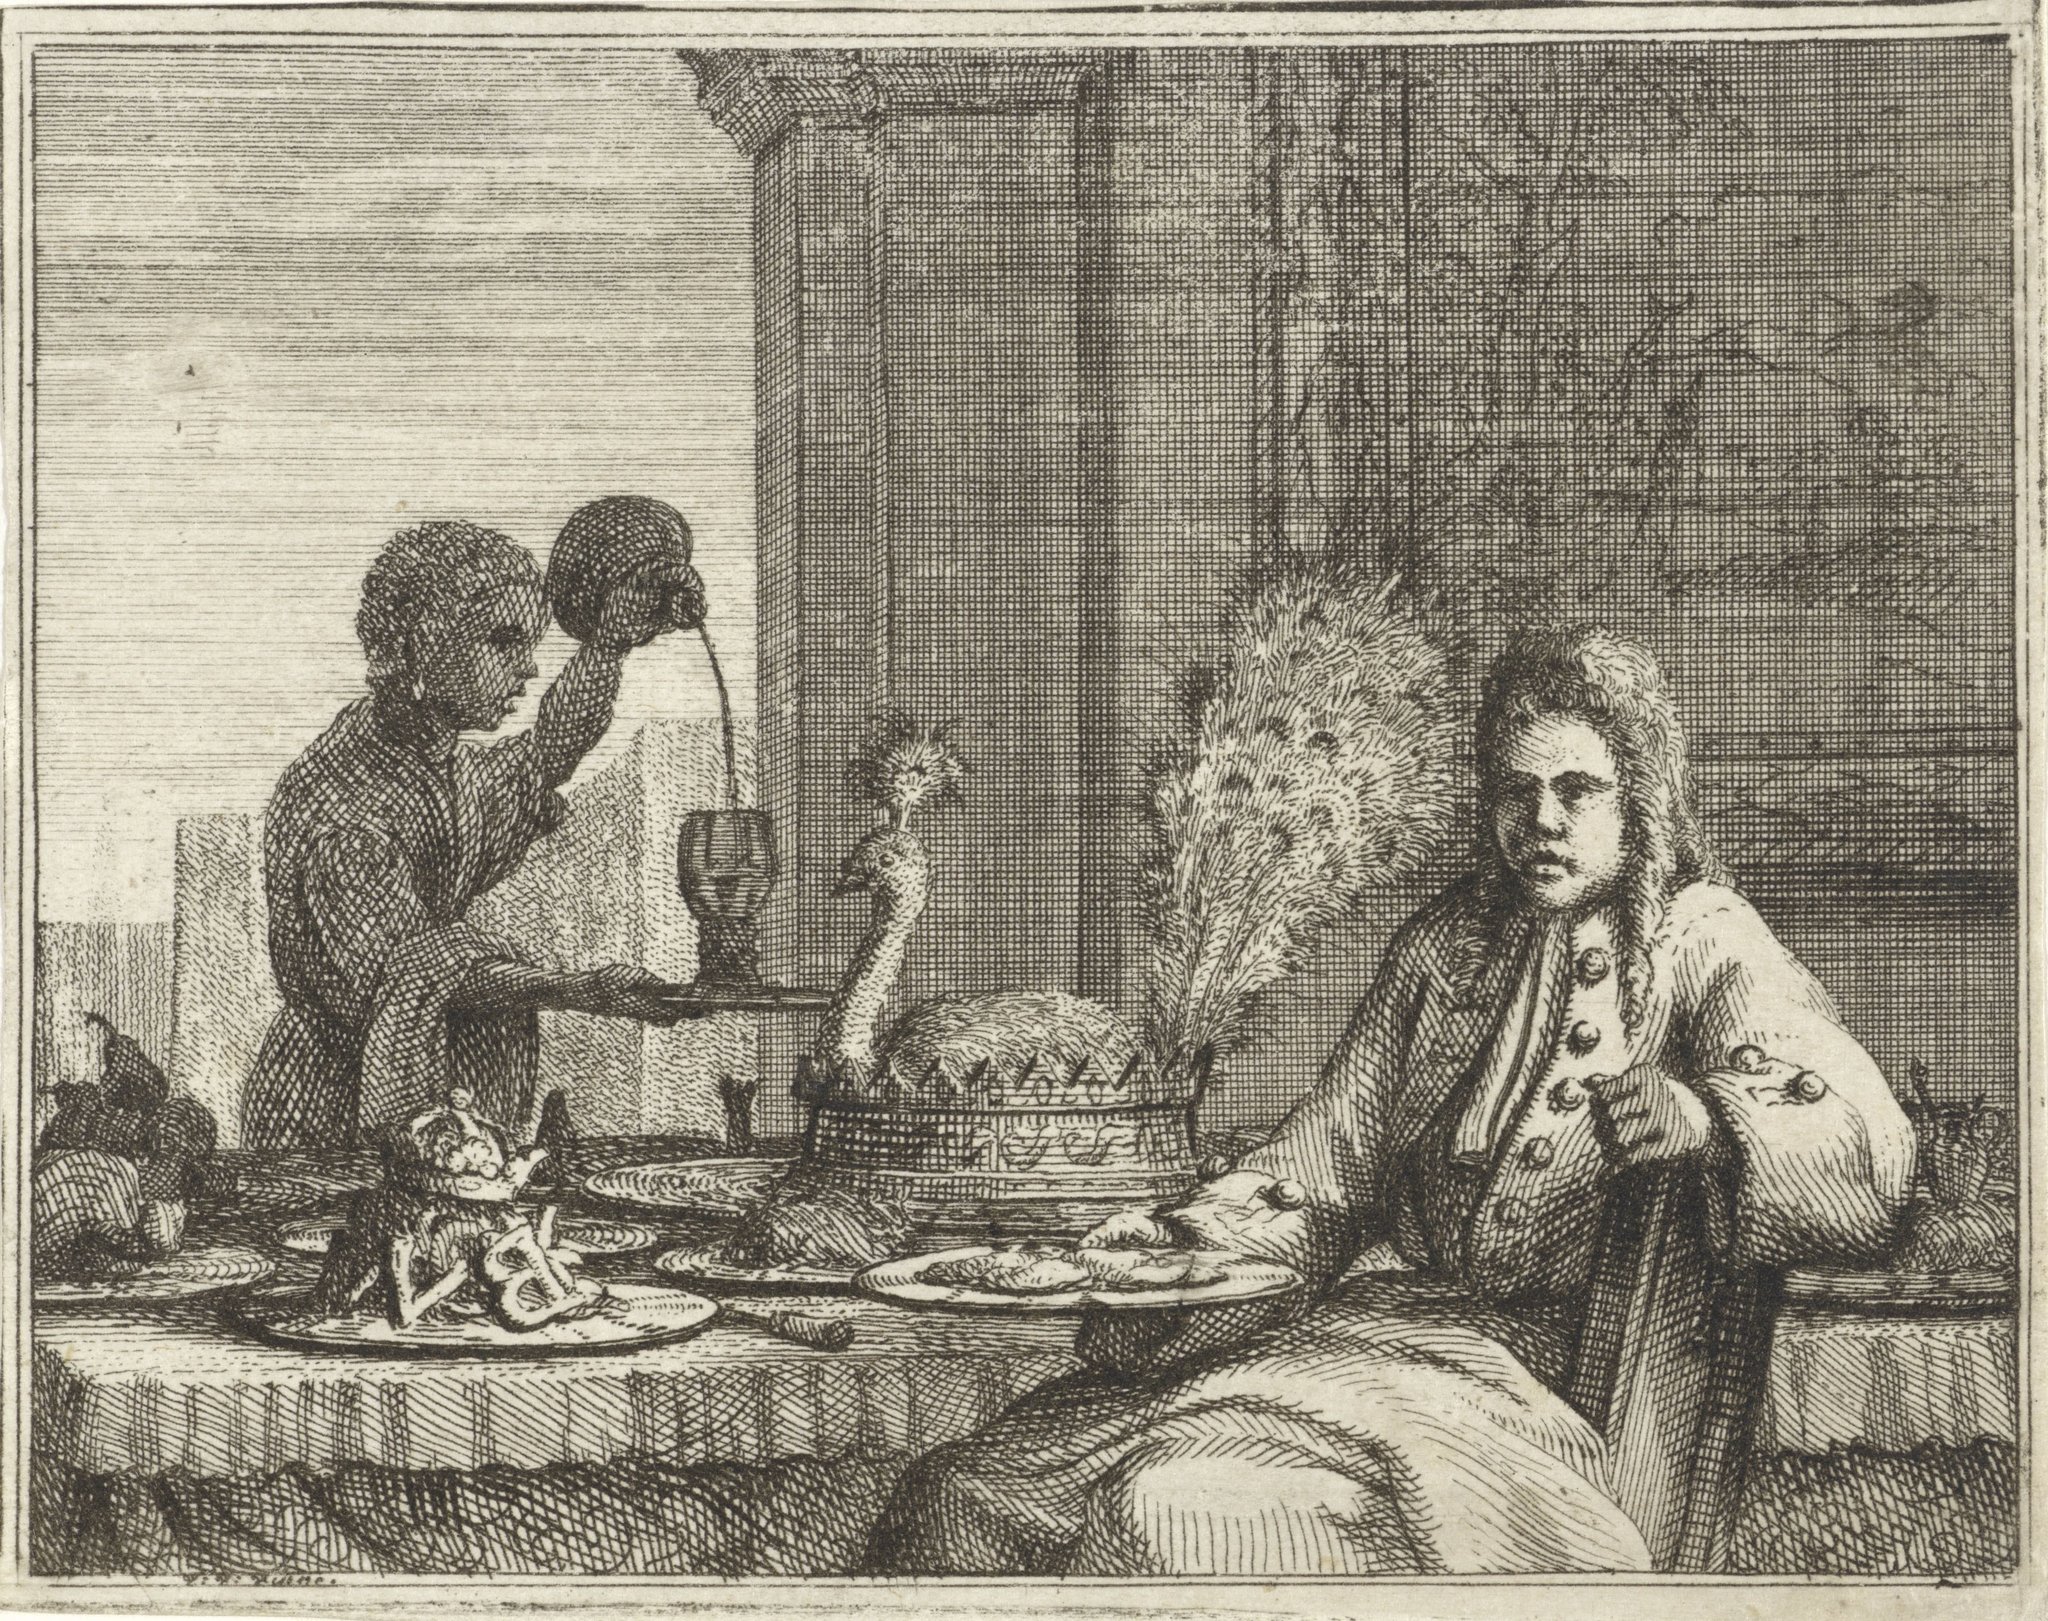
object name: print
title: Man bij een gedekte tafel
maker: vincent laurensz. van der vinne (ii)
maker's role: draughtsman, print maker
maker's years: 1686-1742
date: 1714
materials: paper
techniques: etching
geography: haarlem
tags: celebration meal, feast, banquet, wine-steward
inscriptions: collector's mark: Lugt 2228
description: Een man zit op een stoel bij een rijk gedekte tafel, waarop een pastei met een pauw. Achter de tafel een dienaar die een glas wijn inschenkt. Zinnebeeld op de aardse schijnspijzen, tegenover die van de hemel.